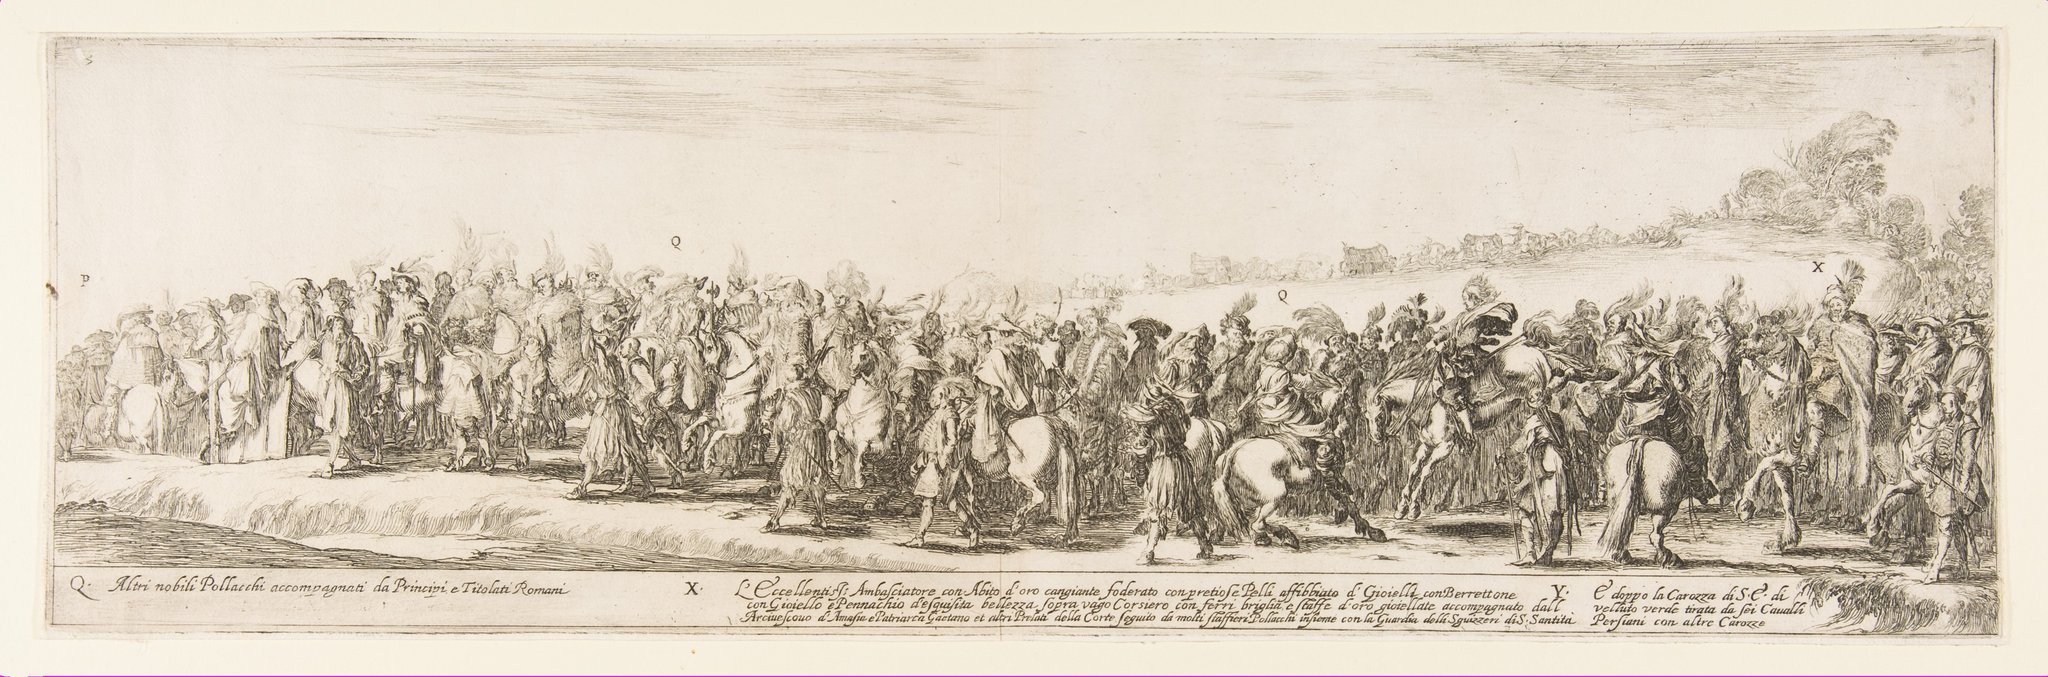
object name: print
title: Part of the Entrance of the Polish Legation (Q.X.Y.)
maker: stefano della bella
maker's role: artist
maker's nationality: italian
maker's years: 1610-1664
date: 1633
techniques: etching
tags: human figures,horses